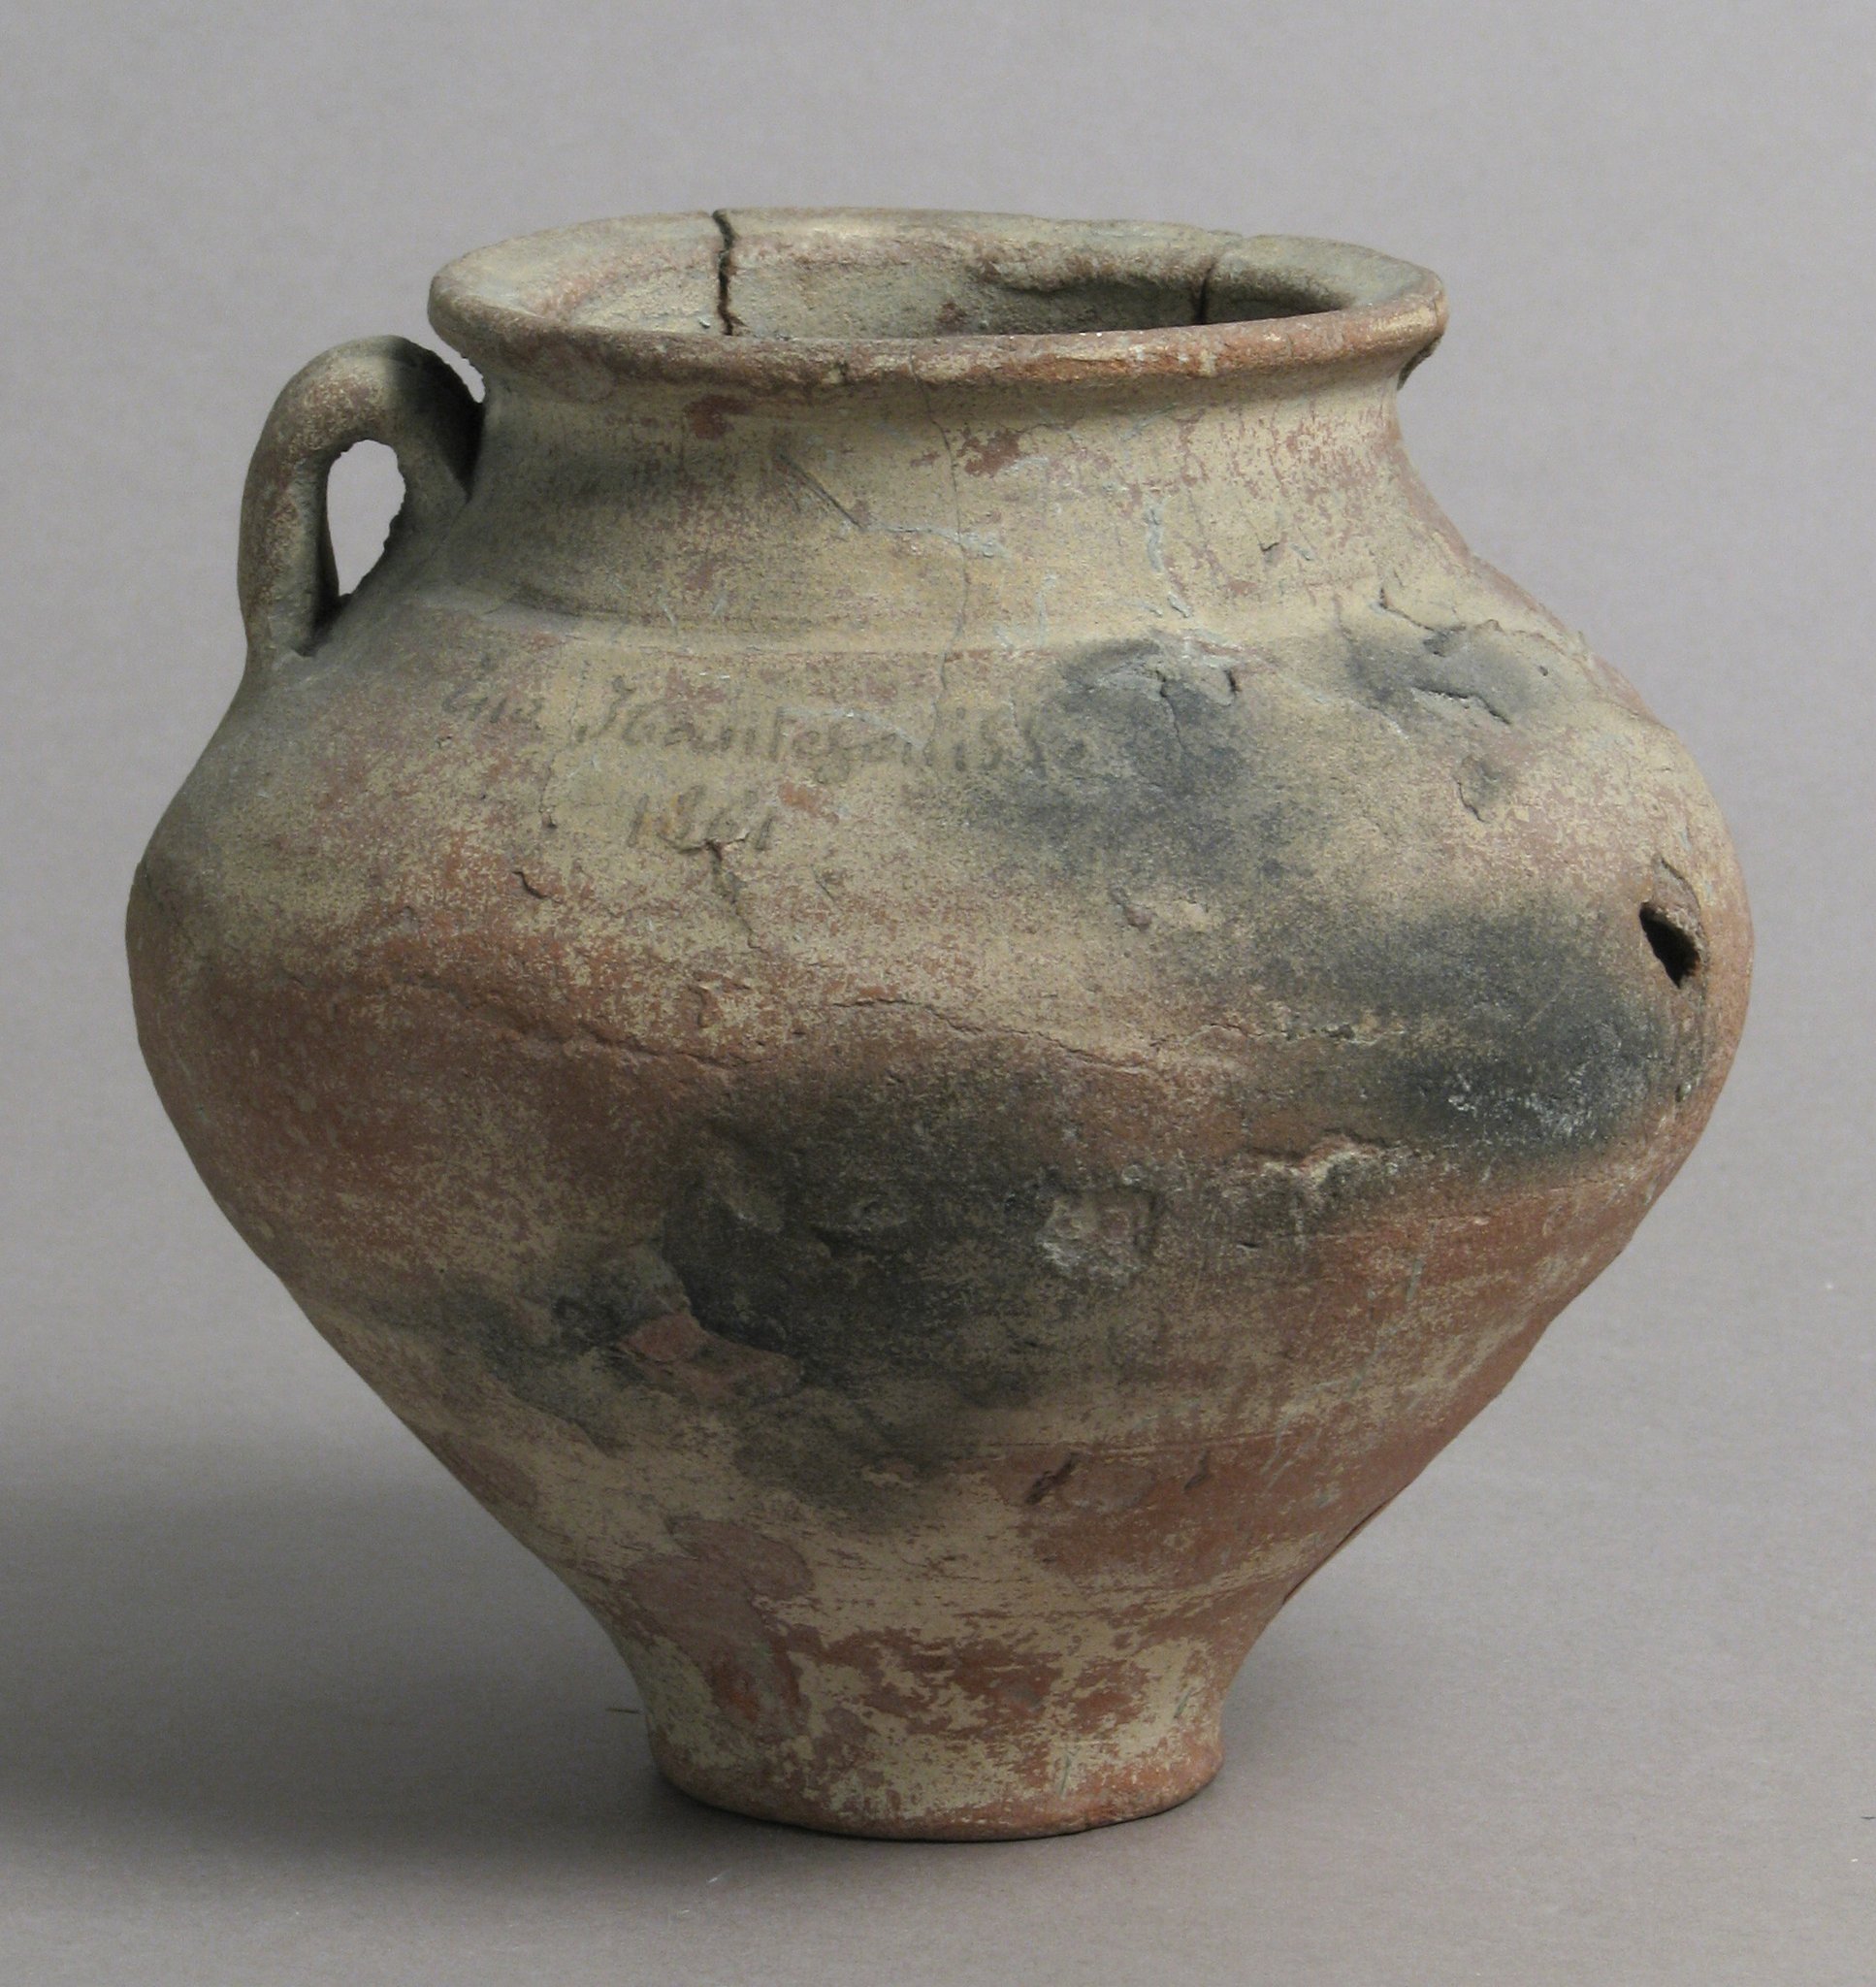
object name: jug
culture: french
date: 1401-1600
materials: earthenware